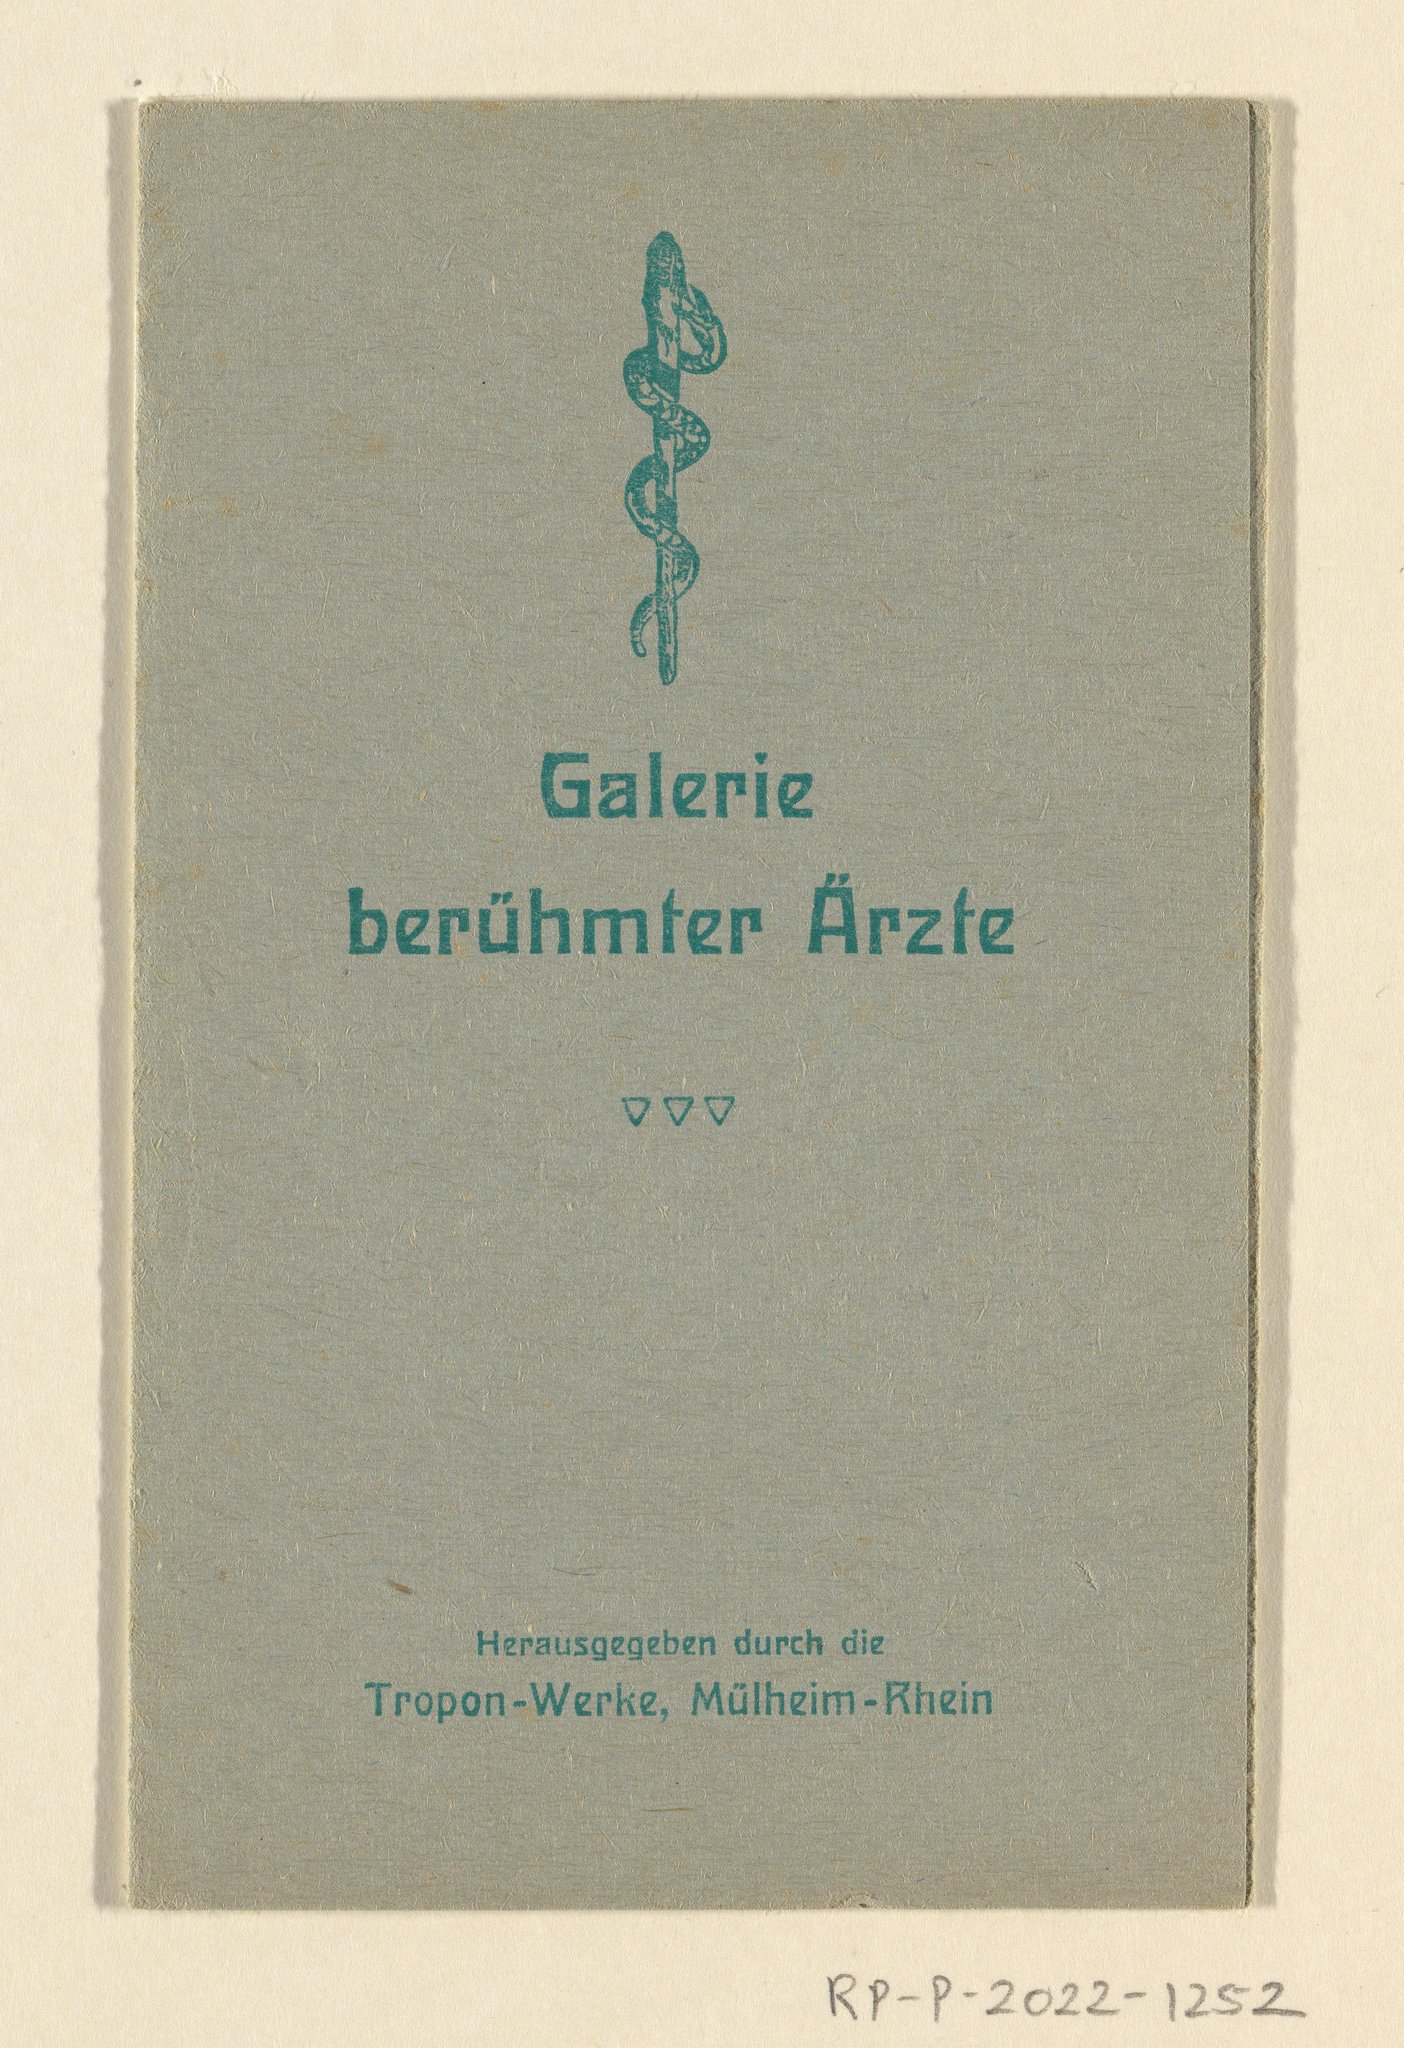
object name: text sheet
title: Galerie berühmter Ärzte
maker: Anonymous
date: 1910-1915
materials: paper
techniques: lithograph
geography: germany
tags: advertising, physician, doctor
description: Boekje met een lijst van de portretten van artsen verschenen in de reeks Galerie berühmter Ärzte. Onderdeel van de serie kaarten in reliëfdruk uitgebracht als reclame voor de medische producten van Tropon-Werke, Mülheim am Rhein.